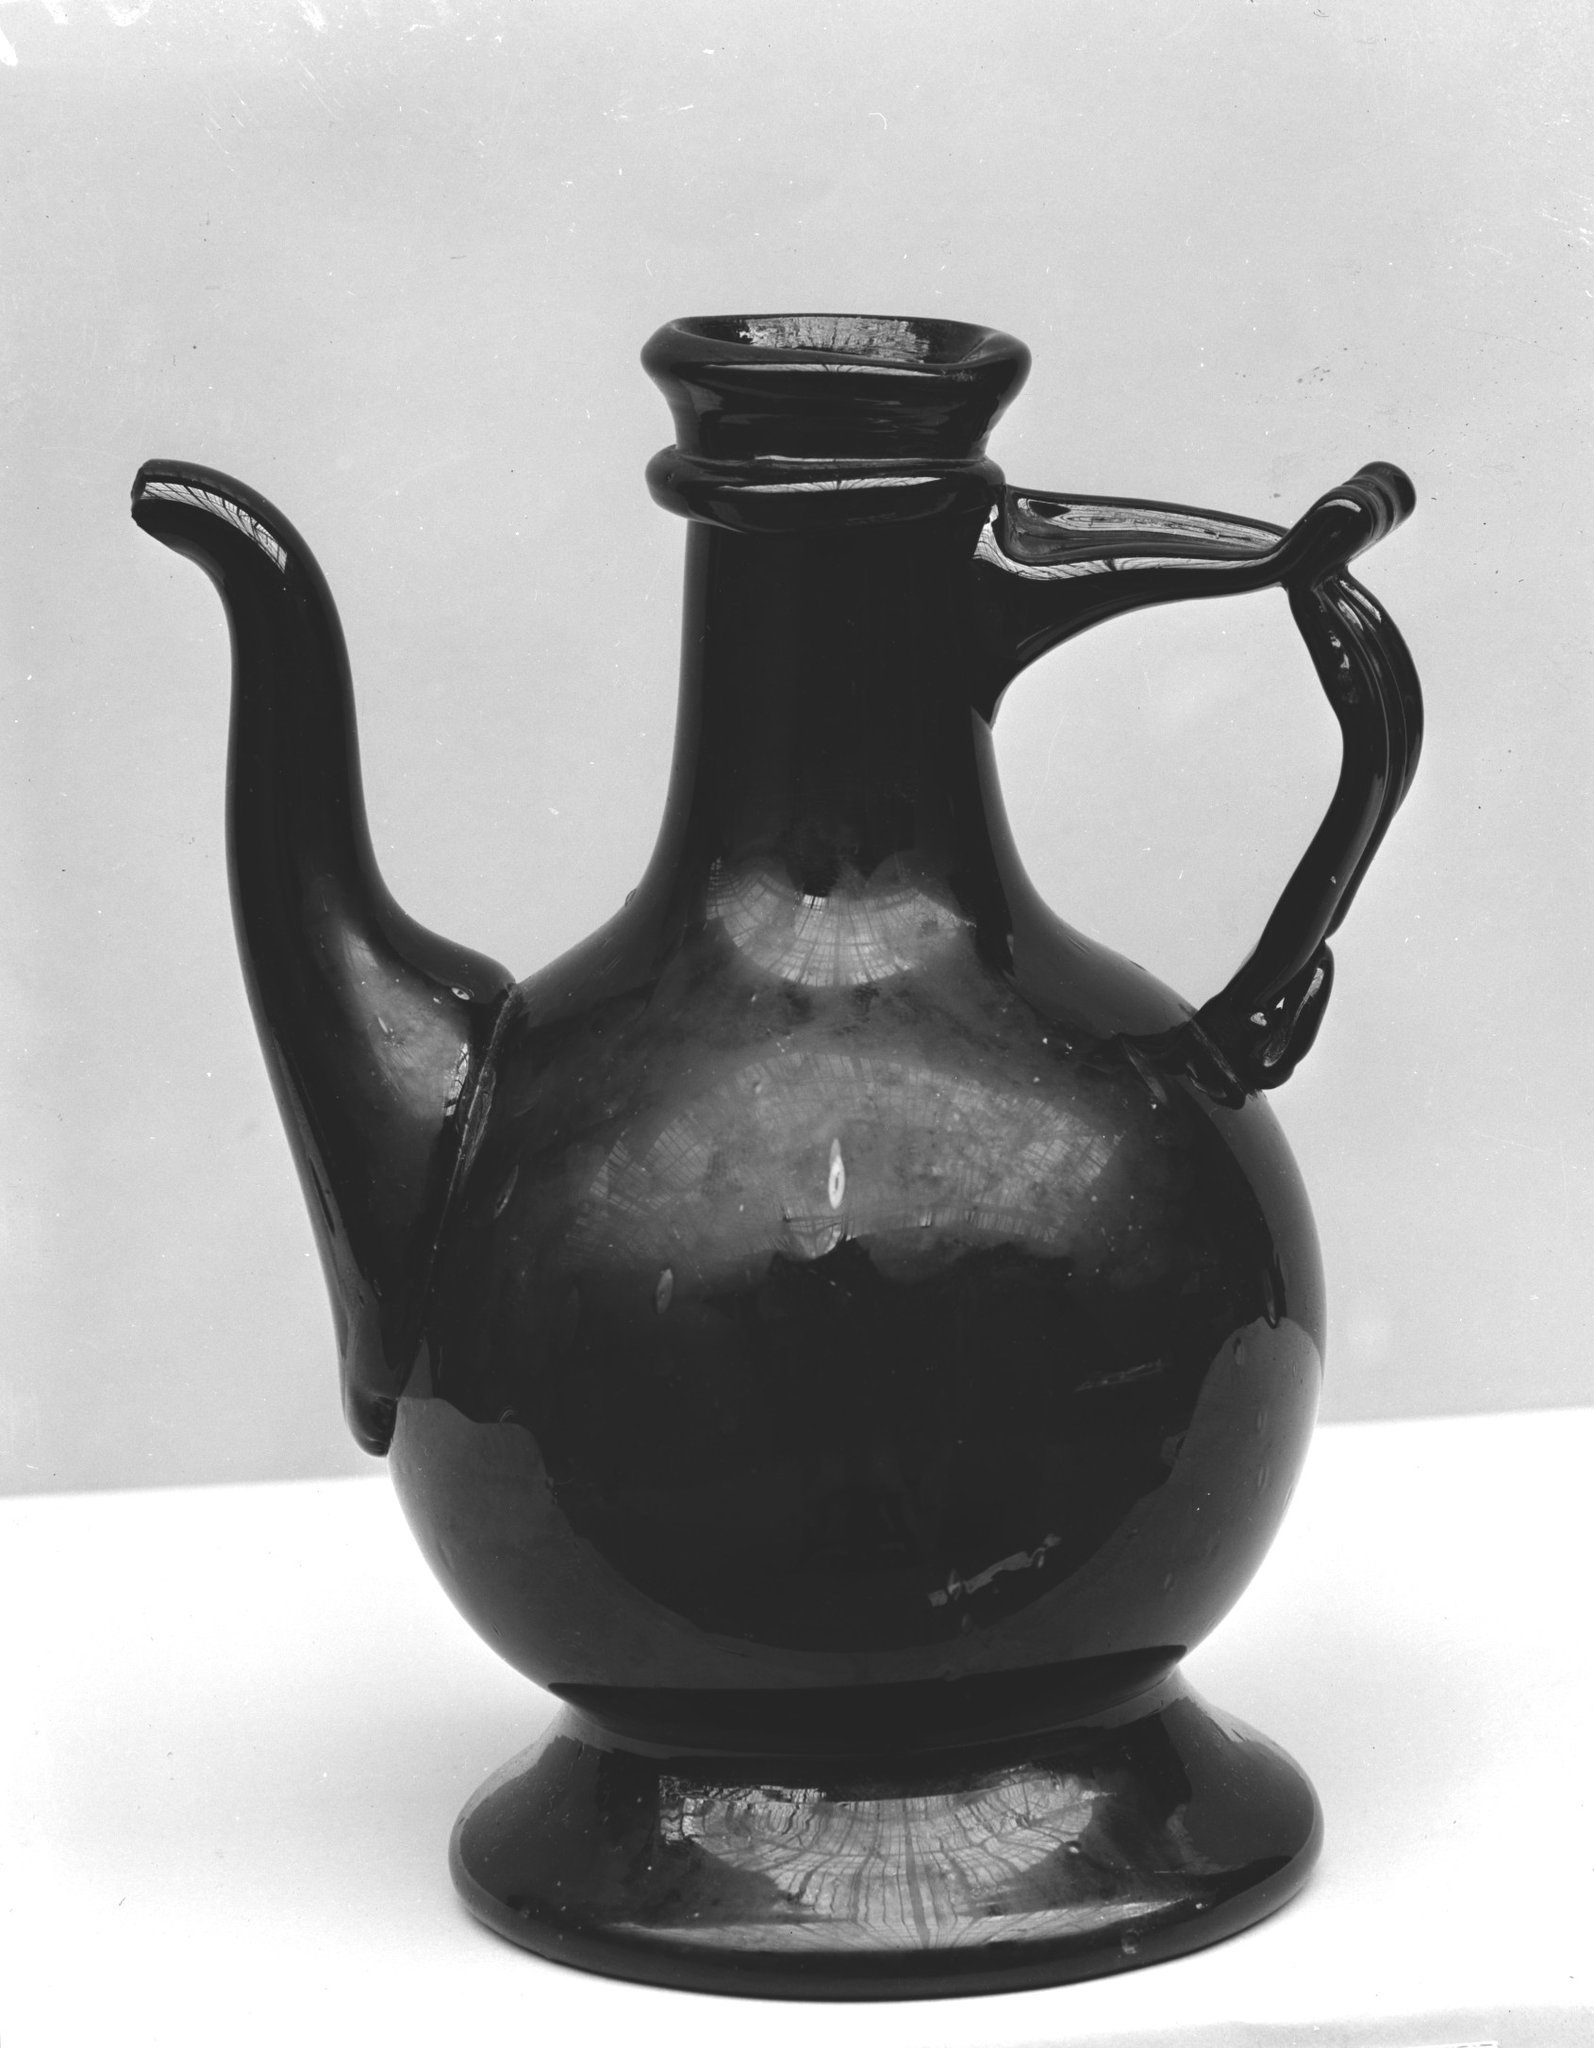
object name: ewer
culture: american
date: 1825-1850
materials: glass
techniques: glassblowing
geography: united states